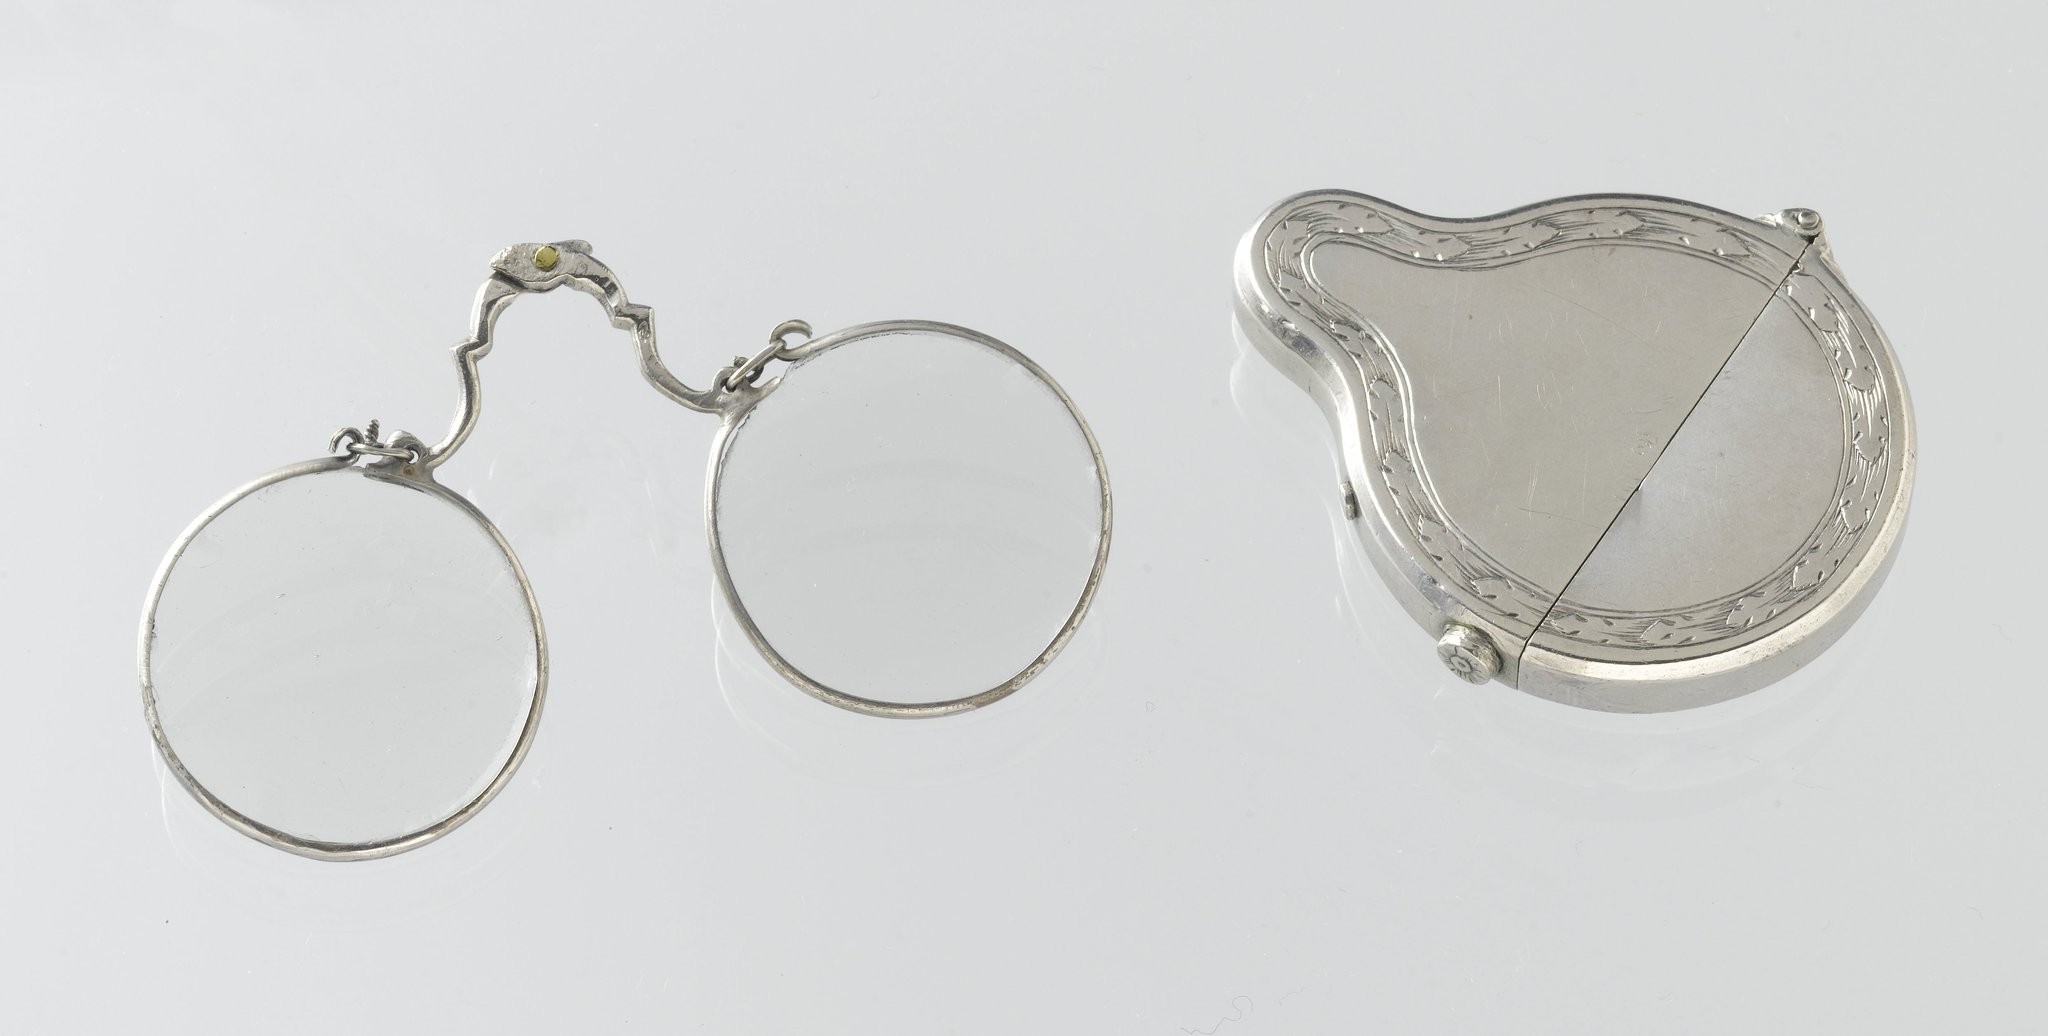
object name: brillenkoker, brillenetui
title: Brillendoos van Willem Credo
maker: Anonymous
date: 1733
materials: silver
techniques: forging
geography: netherlands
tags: kapitein, willem credo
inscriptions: mark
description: Brillendoos van zilver versierd met een gestileerde bladrand in reliëf. De doos bestaat uit twee delen, die door middel van een knopje aan de zijkant geopend kunnen worden. De bril past dubbel gevouwen in de doos.